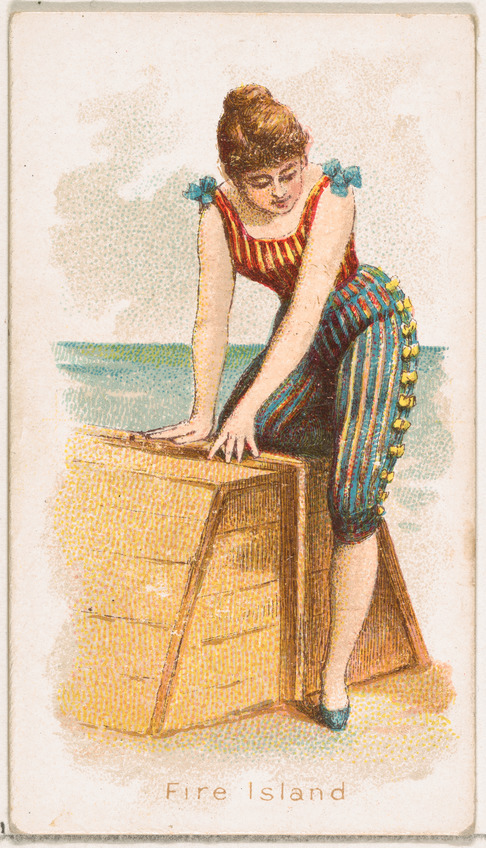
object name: print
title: Fire Island, from the Fancy Bathers series (N187) issued by Wm. S. Kimball & Co.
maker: william s. kimball & company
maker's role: publisher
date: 1889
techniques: color lithograph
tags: women